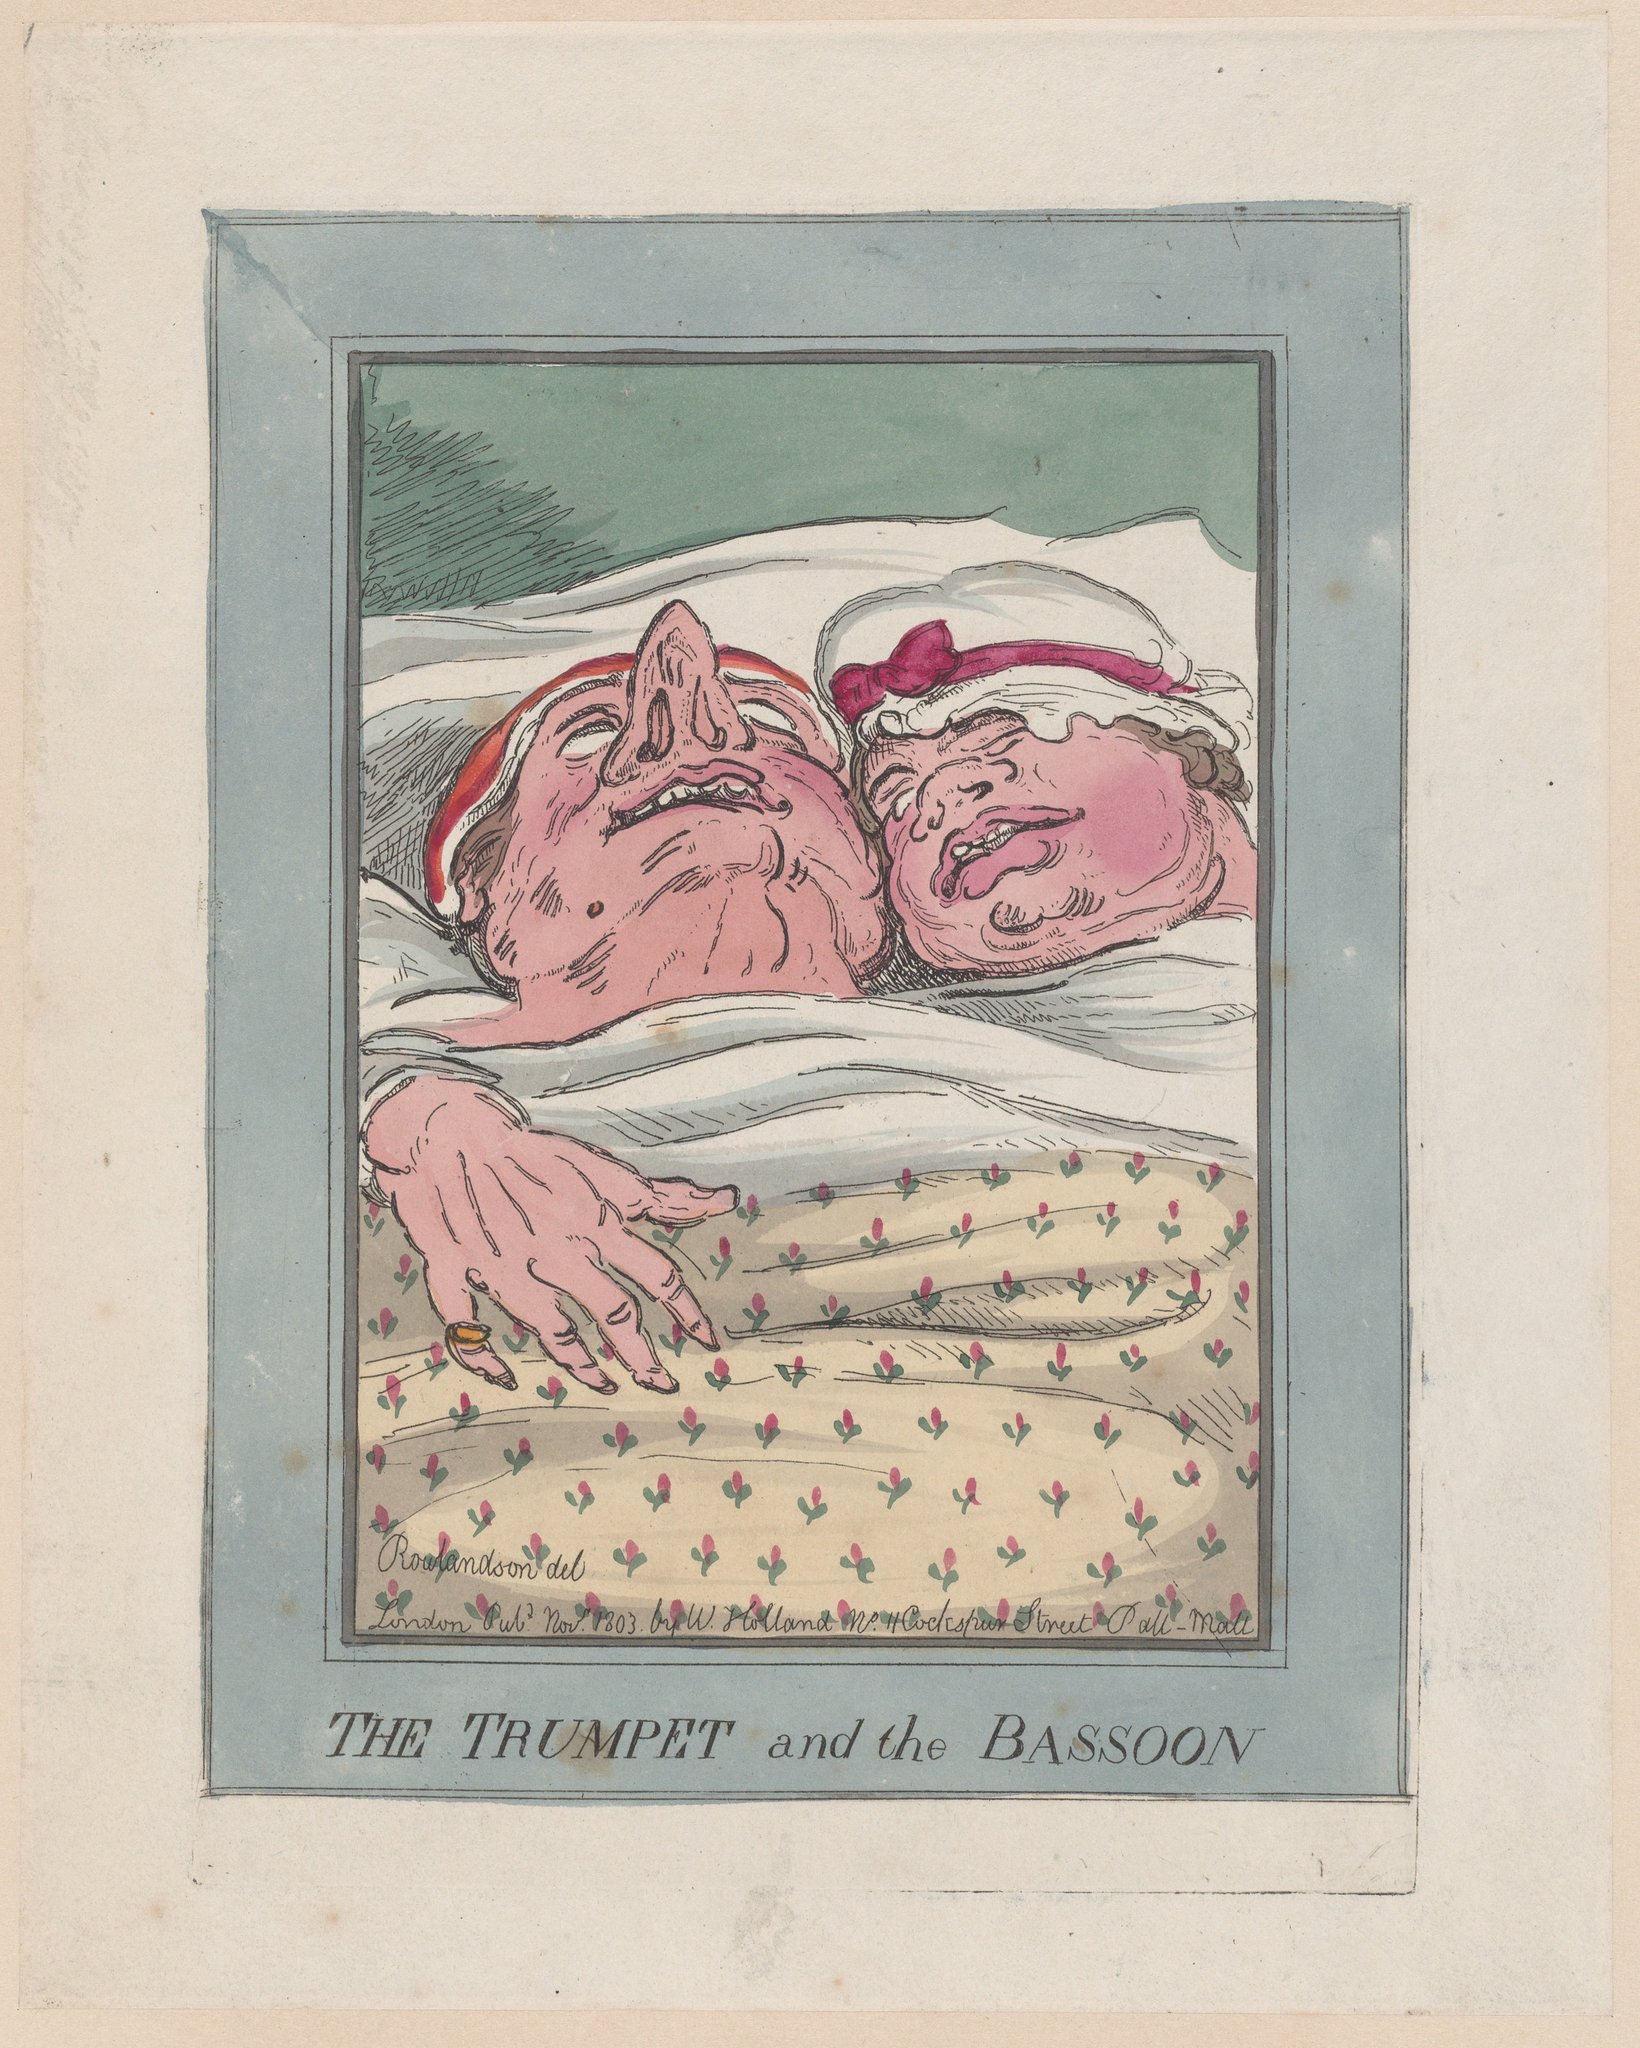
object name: print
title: The Trumpet and the Bassoon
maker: thomas rowlandson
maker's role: artist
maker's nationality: british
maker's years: 1757-1827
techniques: etching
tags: satire,sleeping,men,women